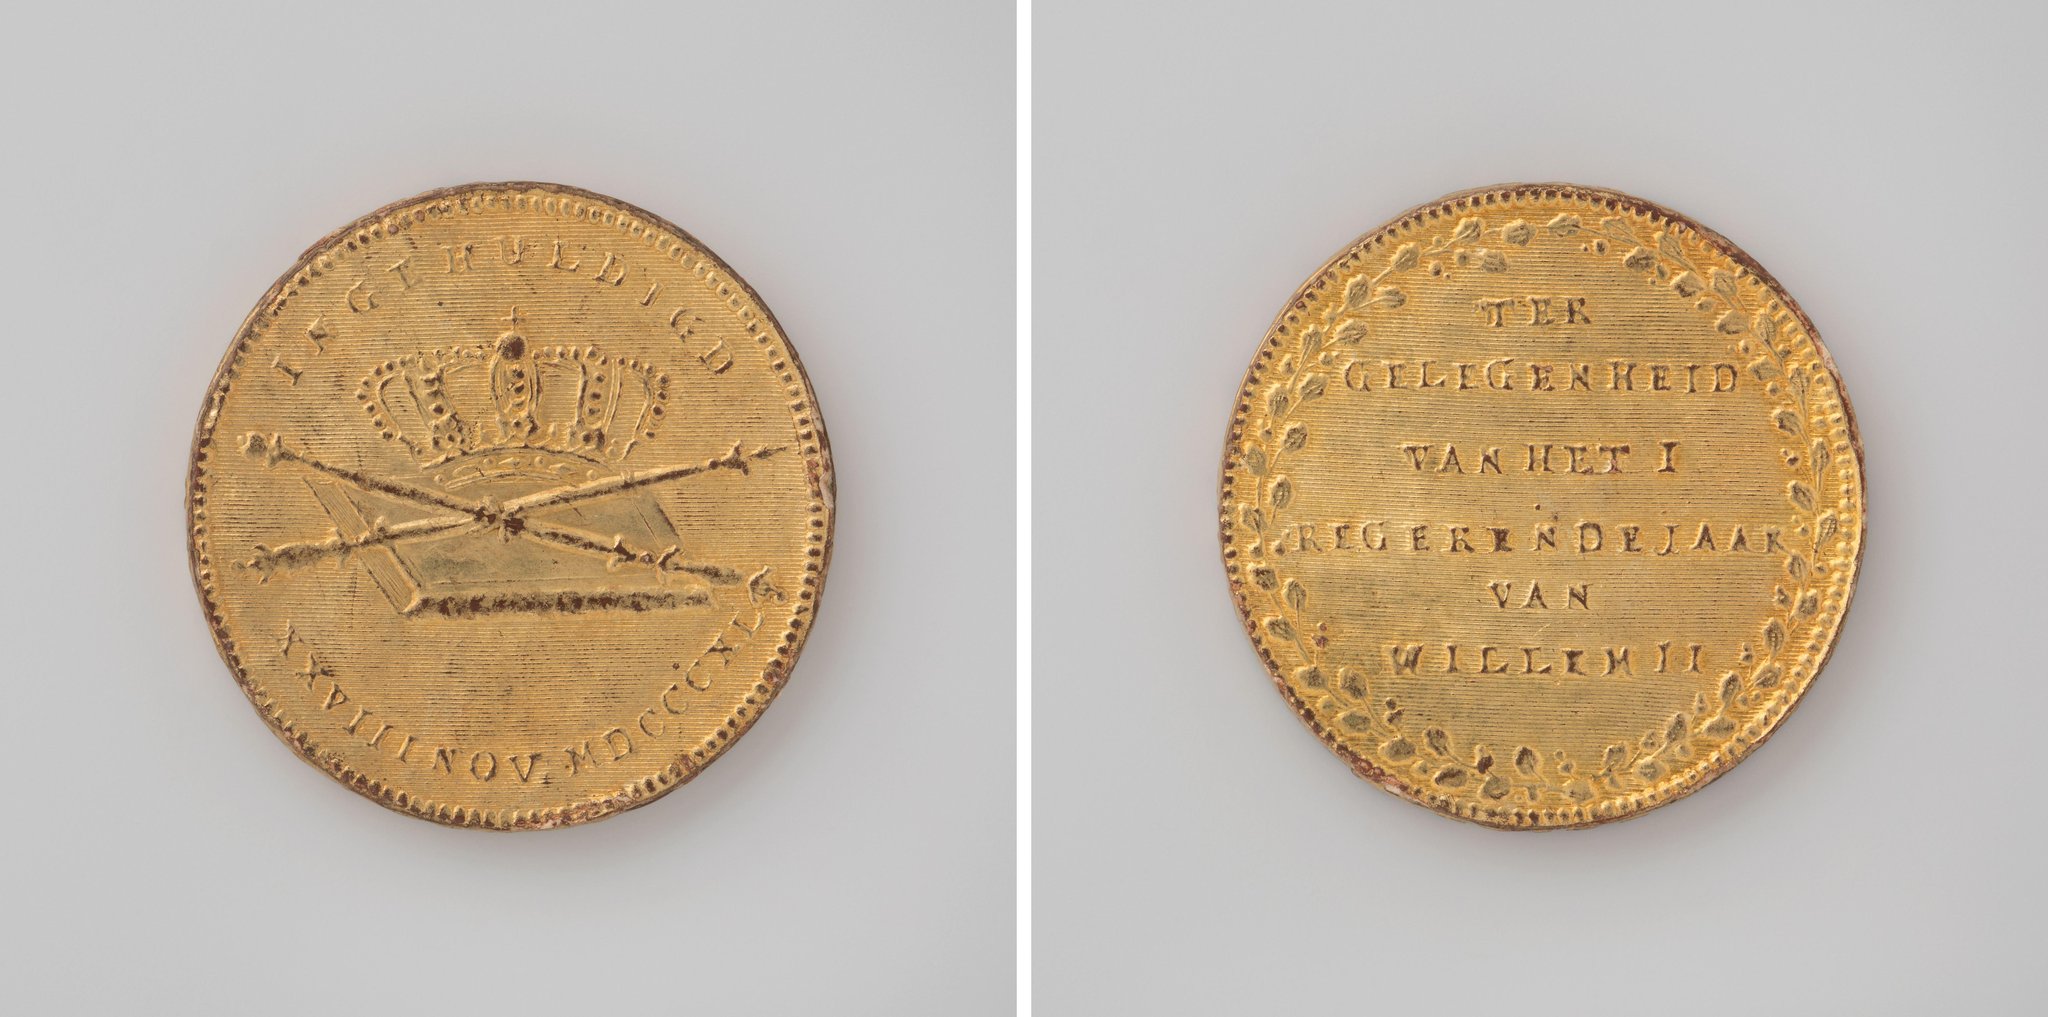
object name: history medal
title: Eerste regeringsjaar van Willem II, koning der Nederlanden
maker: Anonymous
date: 1841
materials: paper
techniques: gilding, striking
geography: netherlands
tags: the hague, william ii of the netherlands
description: Papieren penning met verguldsel. Voorzijde: kroon, liggend op gekruiste scepter en staf, en op boek met opschrift "Grondwet" binnen omschrift. Keerzijde: opschrift binnen krans; randschrift